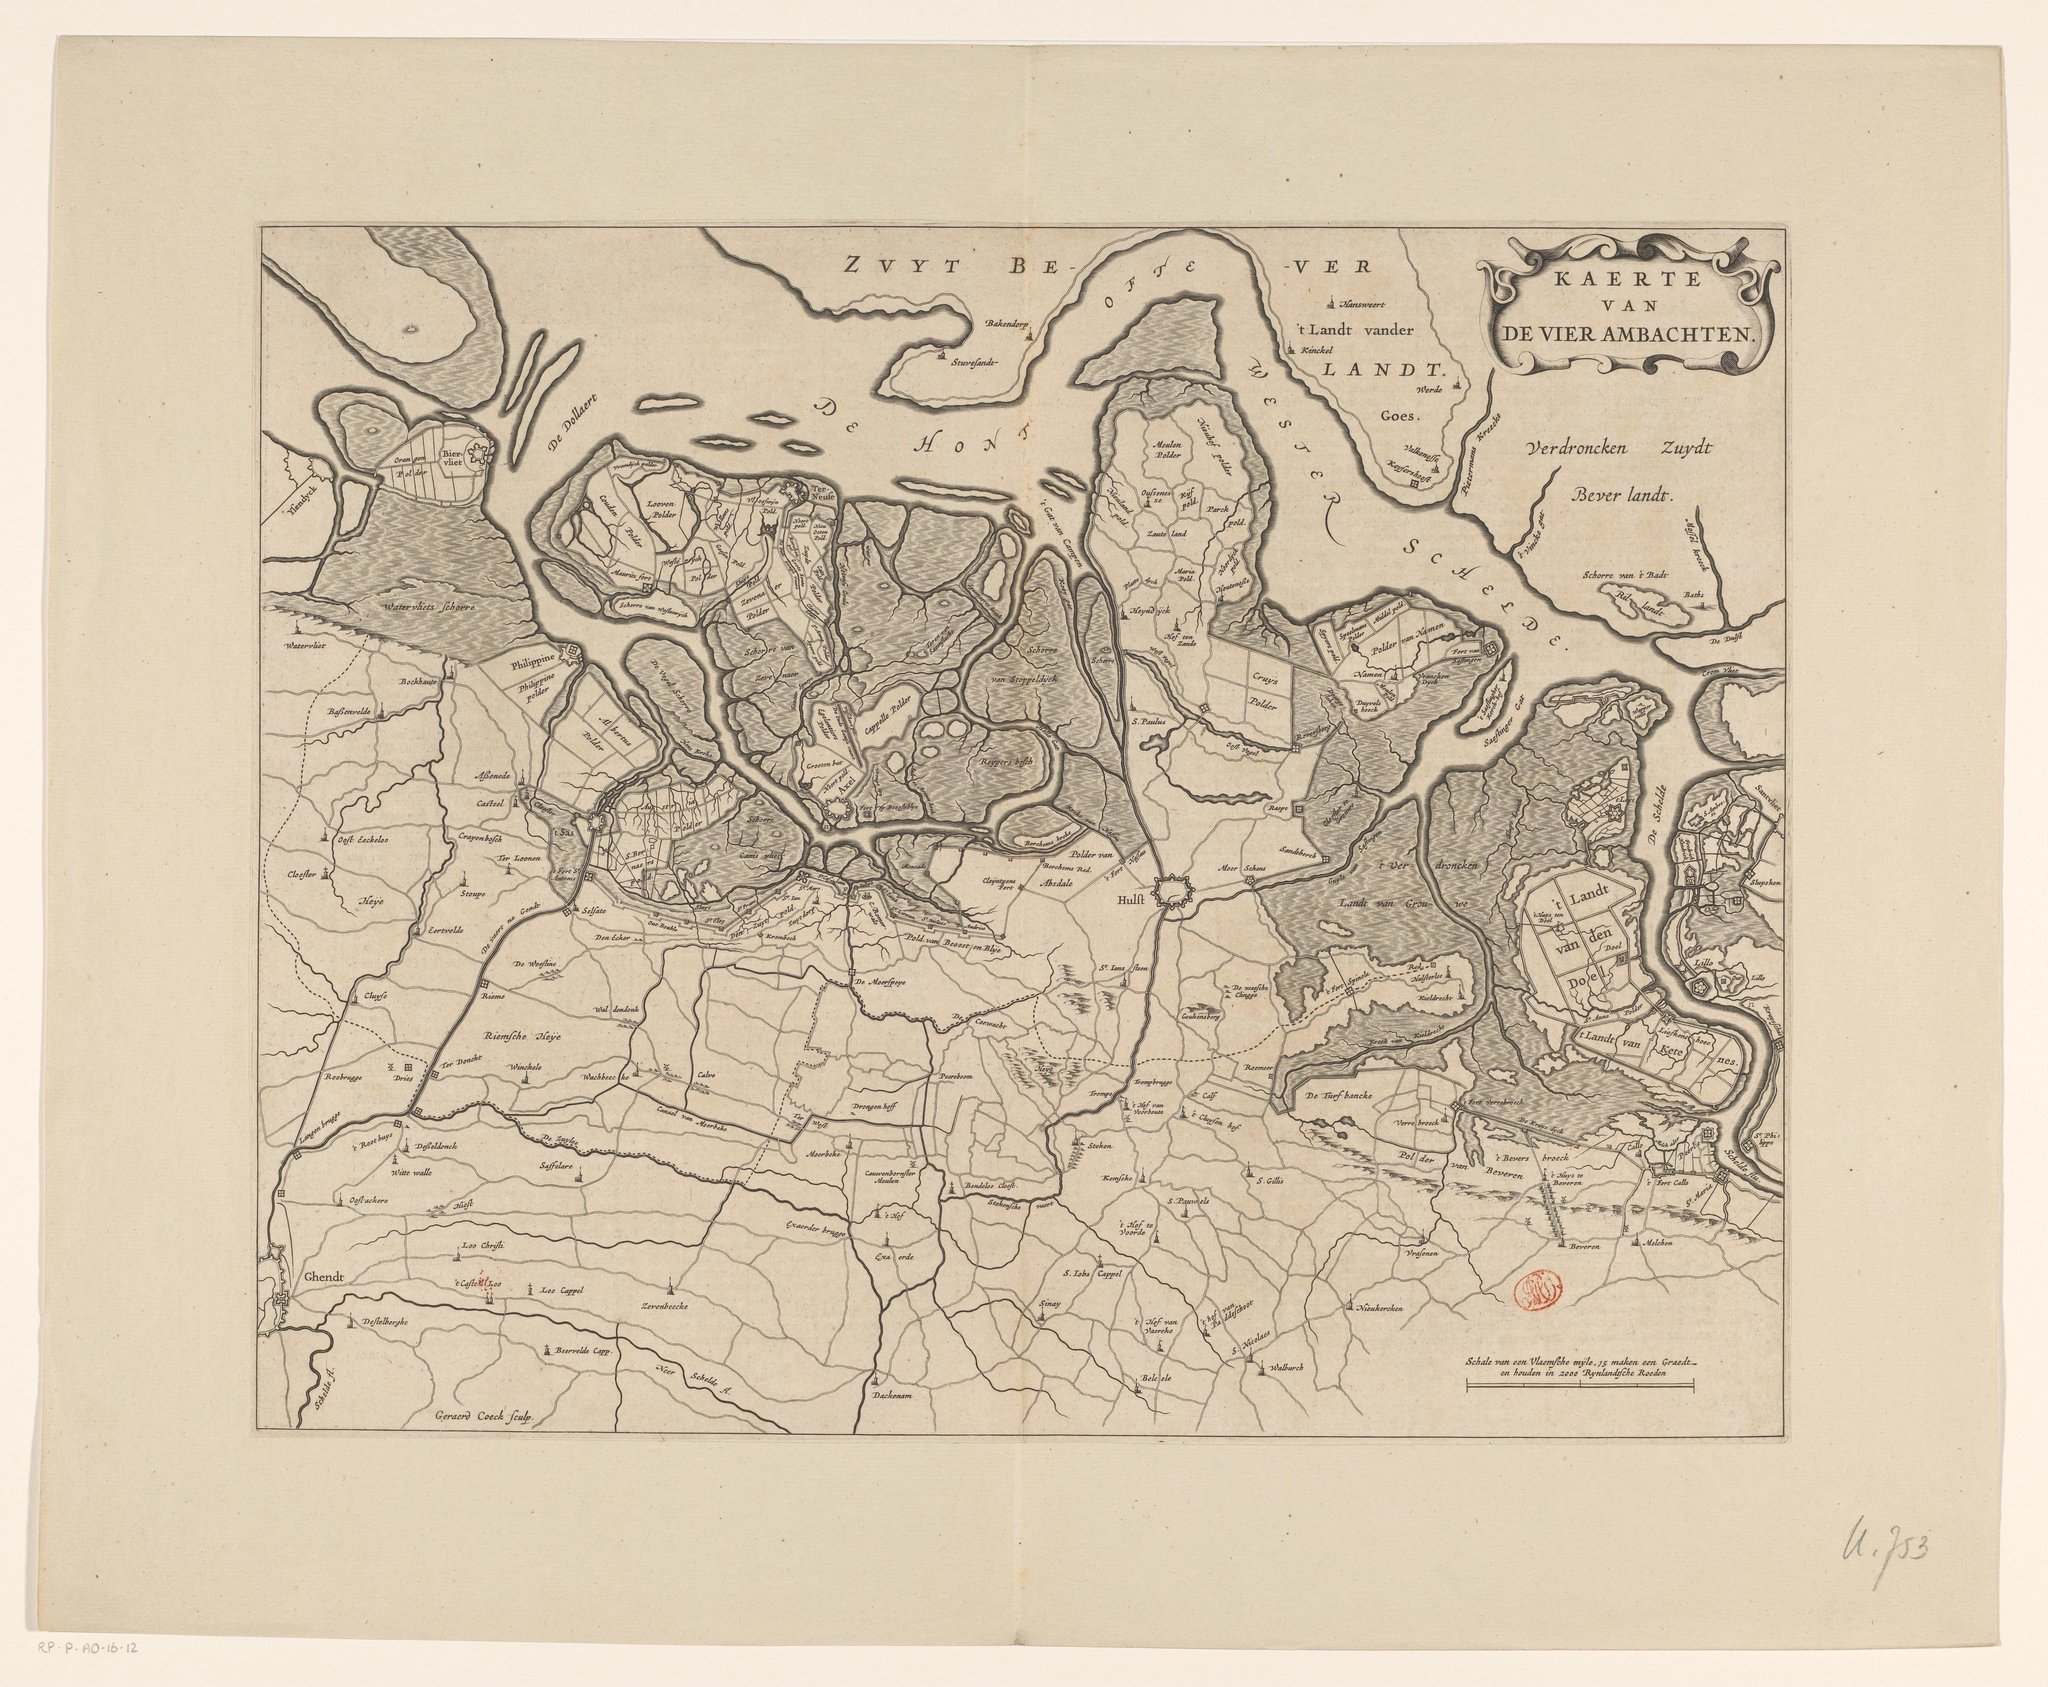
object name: map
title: Kaart van de Vier Ambachten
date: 1644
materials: paper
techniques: engraving, etching, letterpress printing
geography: amsterdam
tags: maps of separate countries or regions, zeeland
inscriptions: collector's mark: Lugt 195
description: Kaart van de Vier Ambachten. Rechtsboven een titelcartouche. Rechtsonder een schaalstok: Schale van een Vlaemsche mijle, 15 maken een Graedt en houden in 2000 Rynlandtsche Roeden. Latijnse tekst op verso.